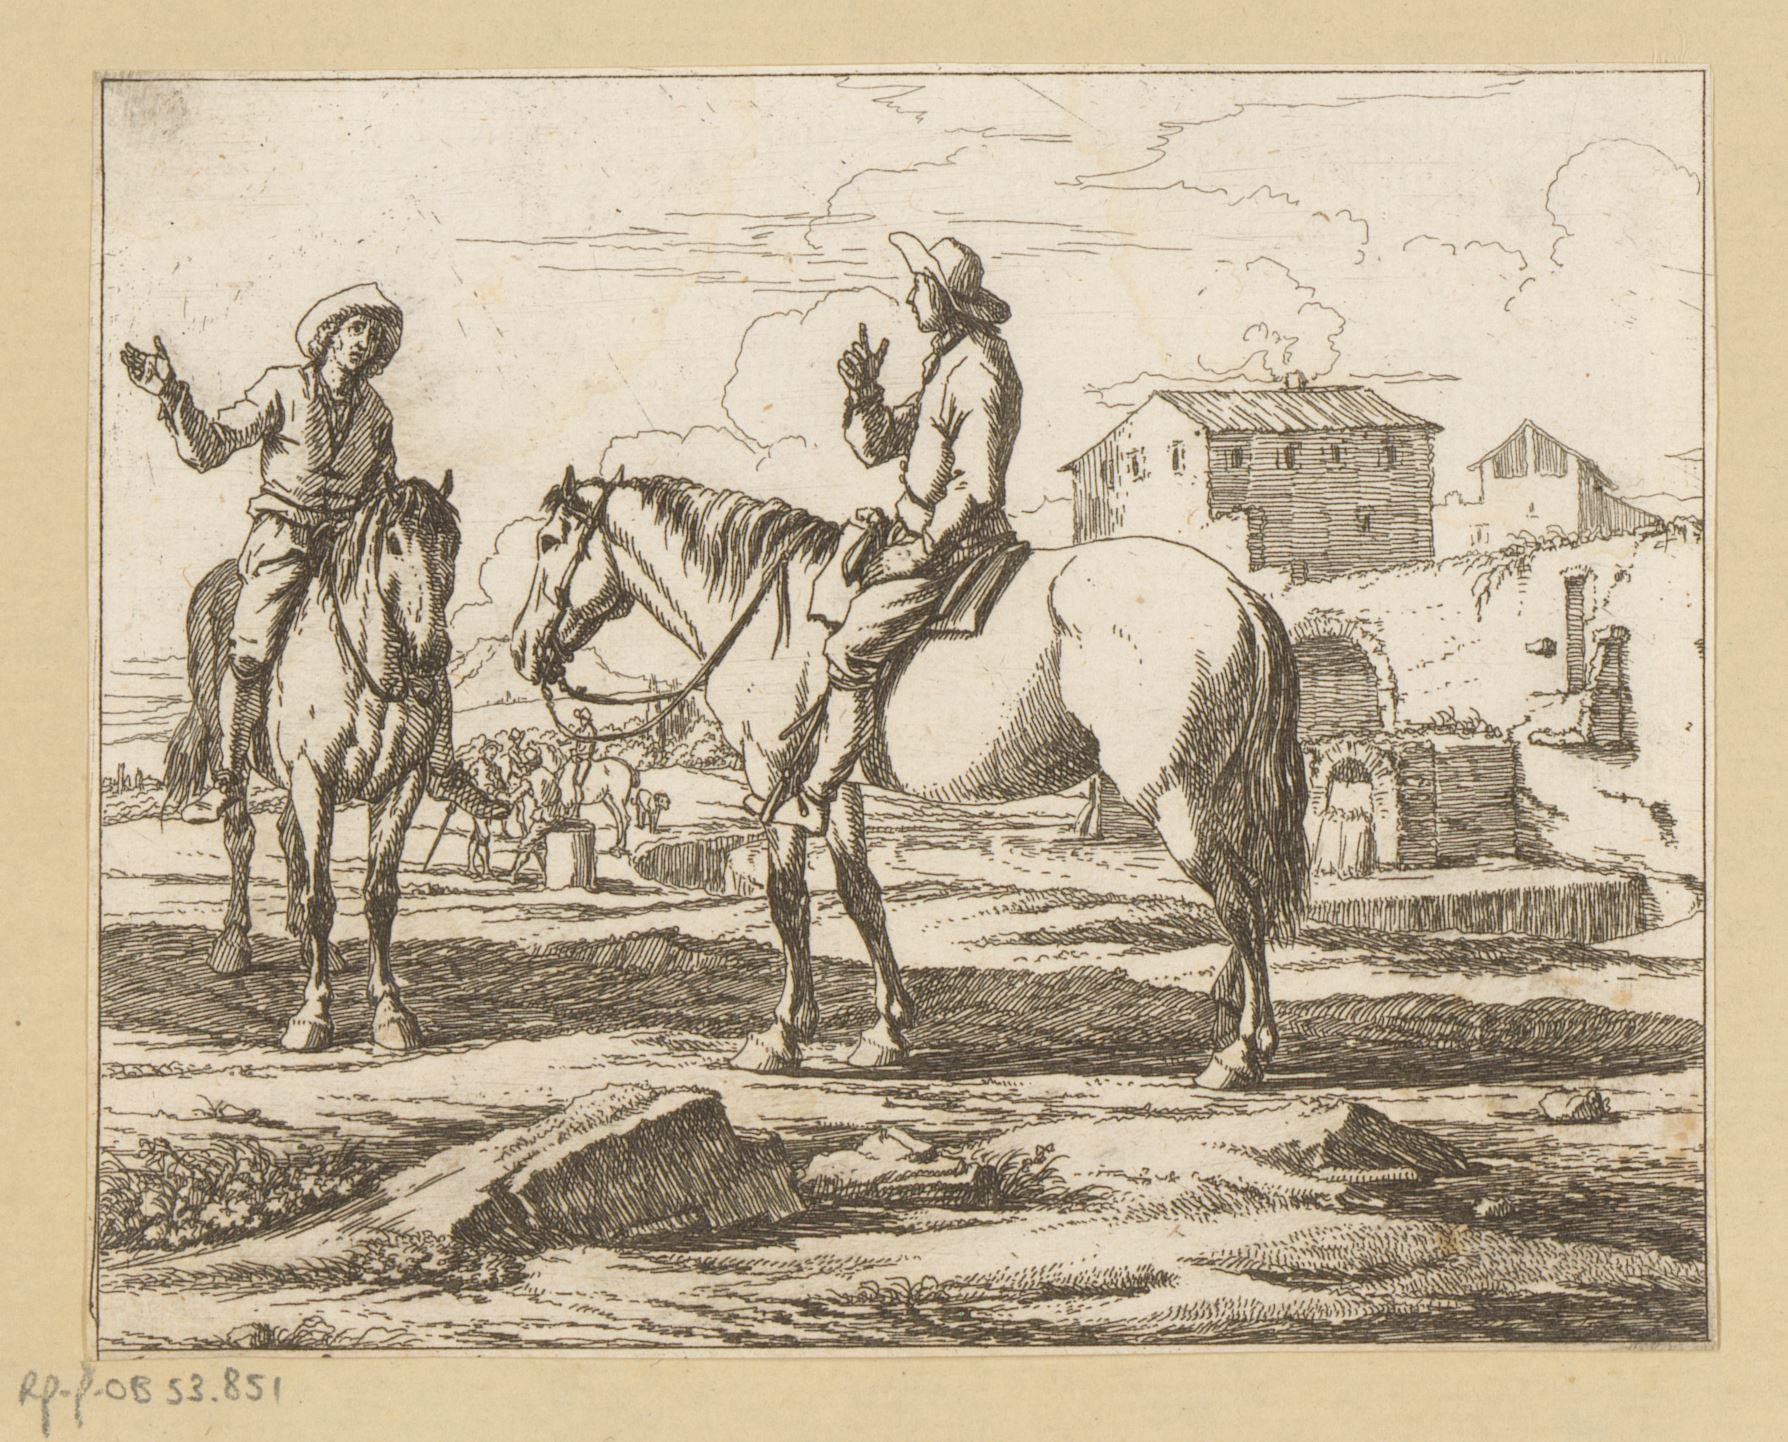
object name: print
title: Diversi Pensieri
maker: georg philipp rugendas (i)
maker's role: draughtsman, print maker, publisher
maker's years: 1666-1742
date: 1676-1742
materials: paper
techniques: etching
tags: riding a horse, ass, or mule; rider, horseman, city-view, and landscape with man-made constructions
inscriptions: collector's mark: Lugt 240